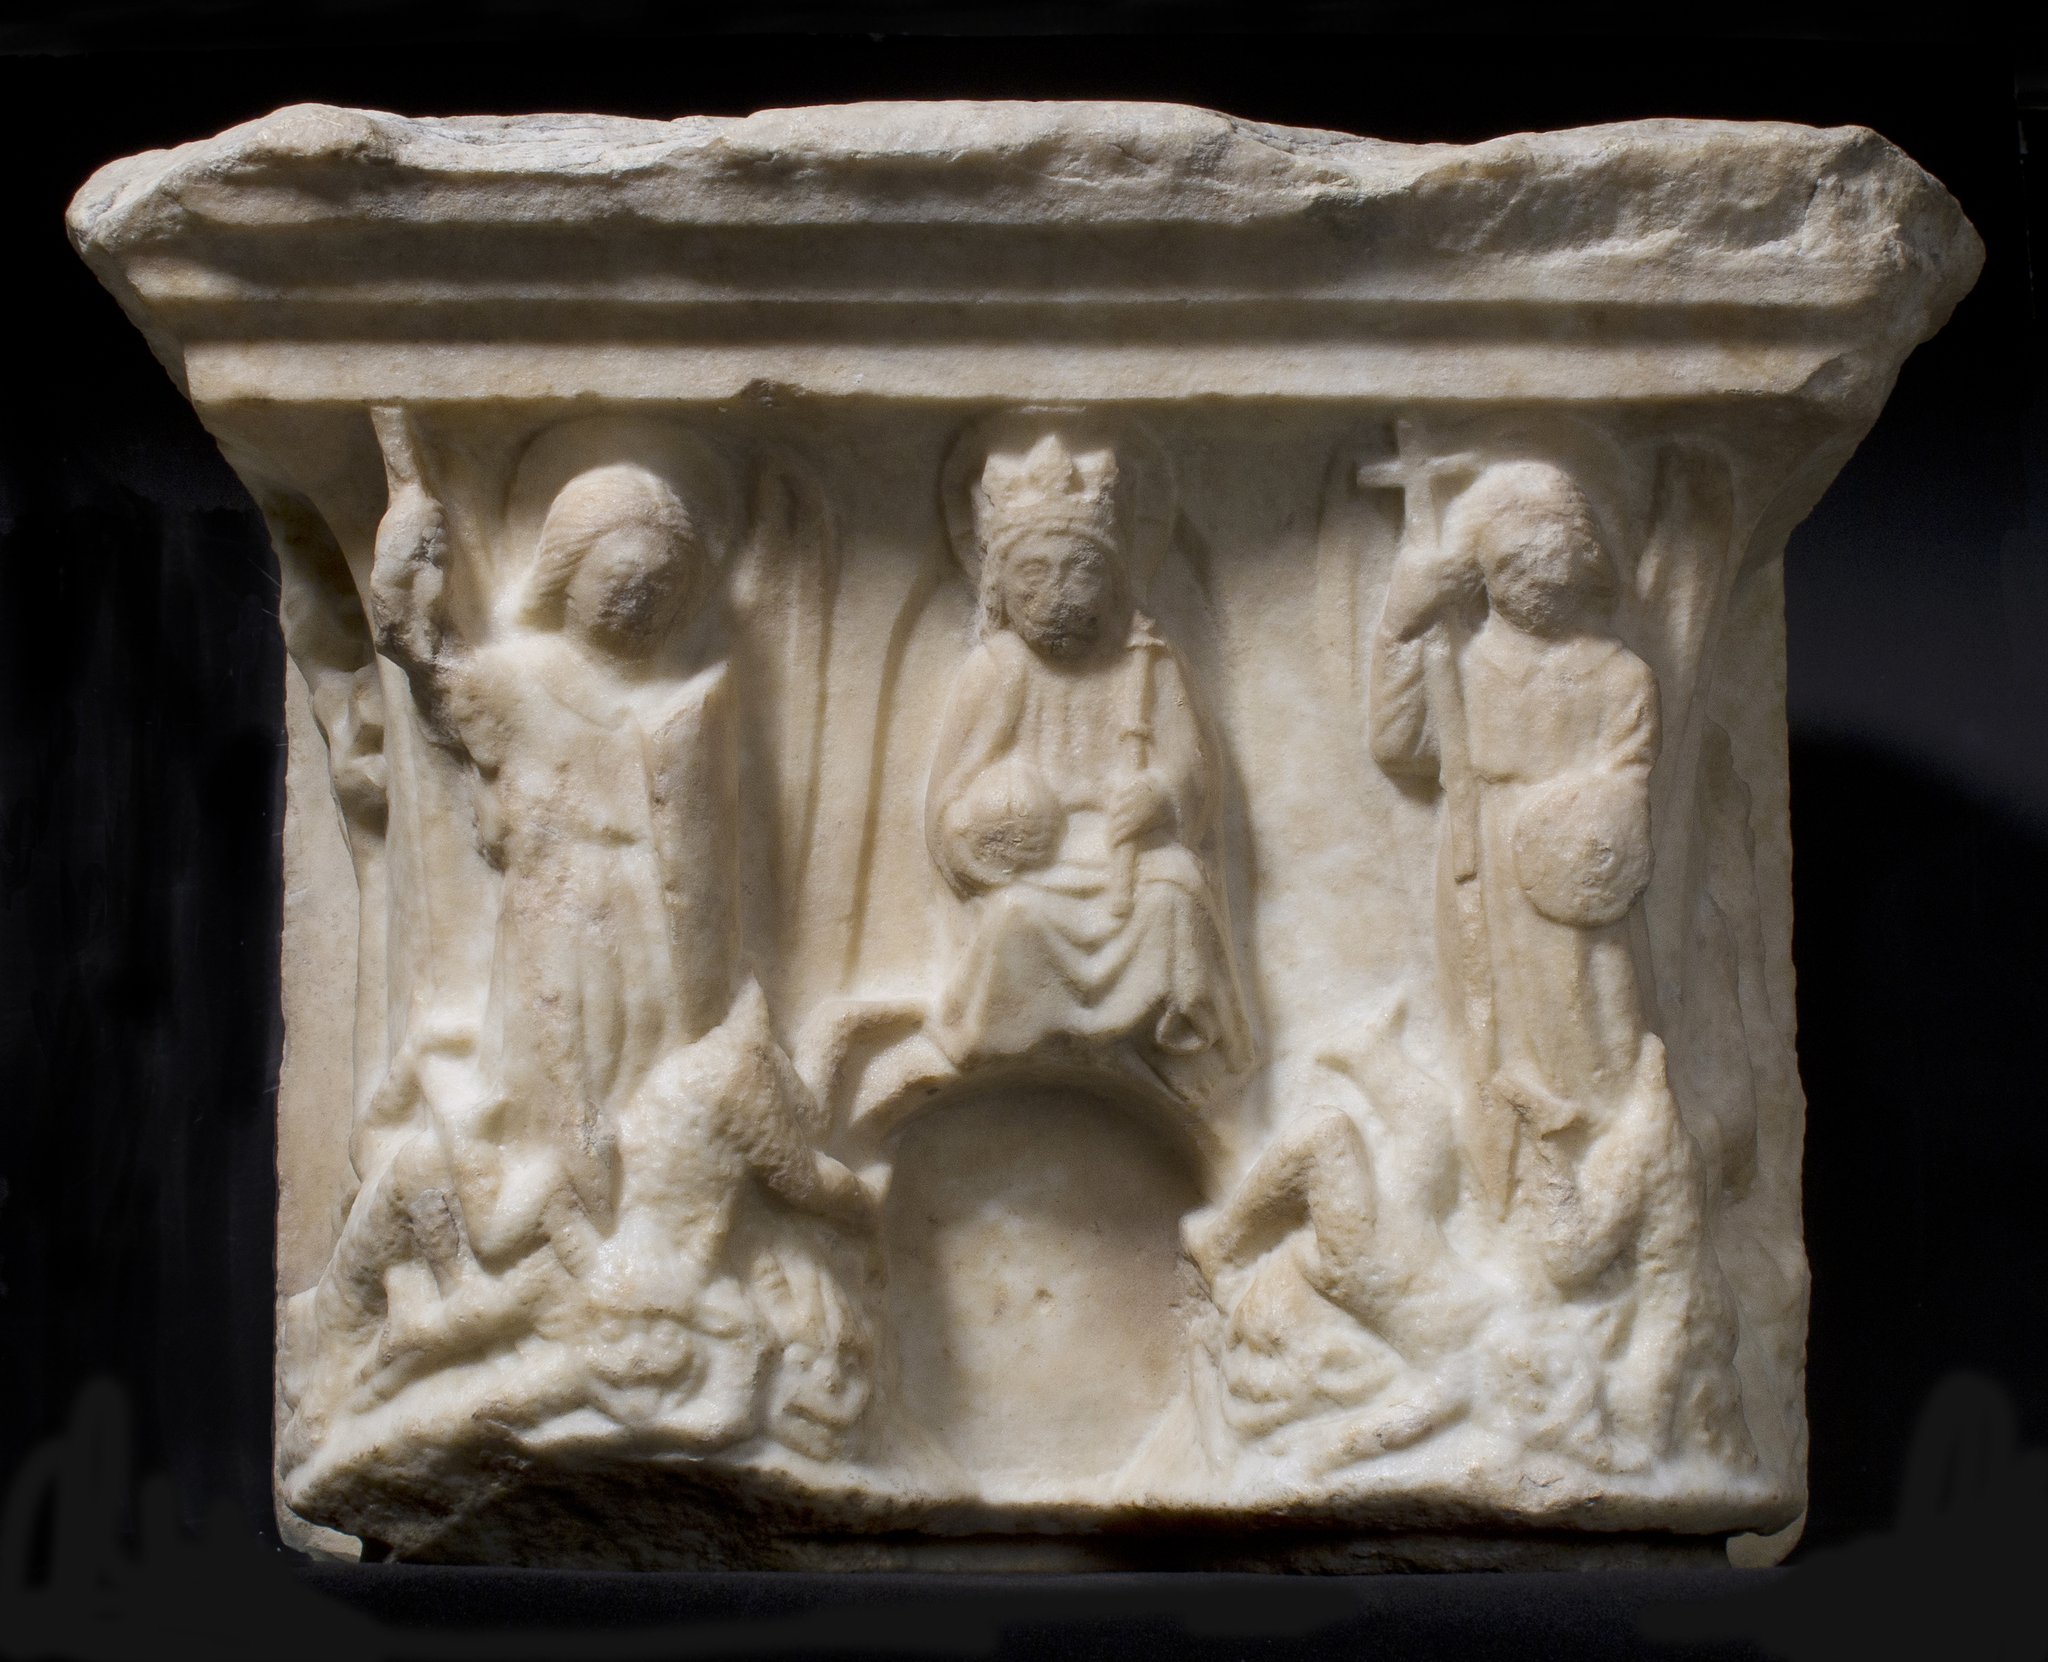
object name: capital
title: Double Capital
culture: french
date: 1467-1500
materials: marble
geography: france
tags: god the father